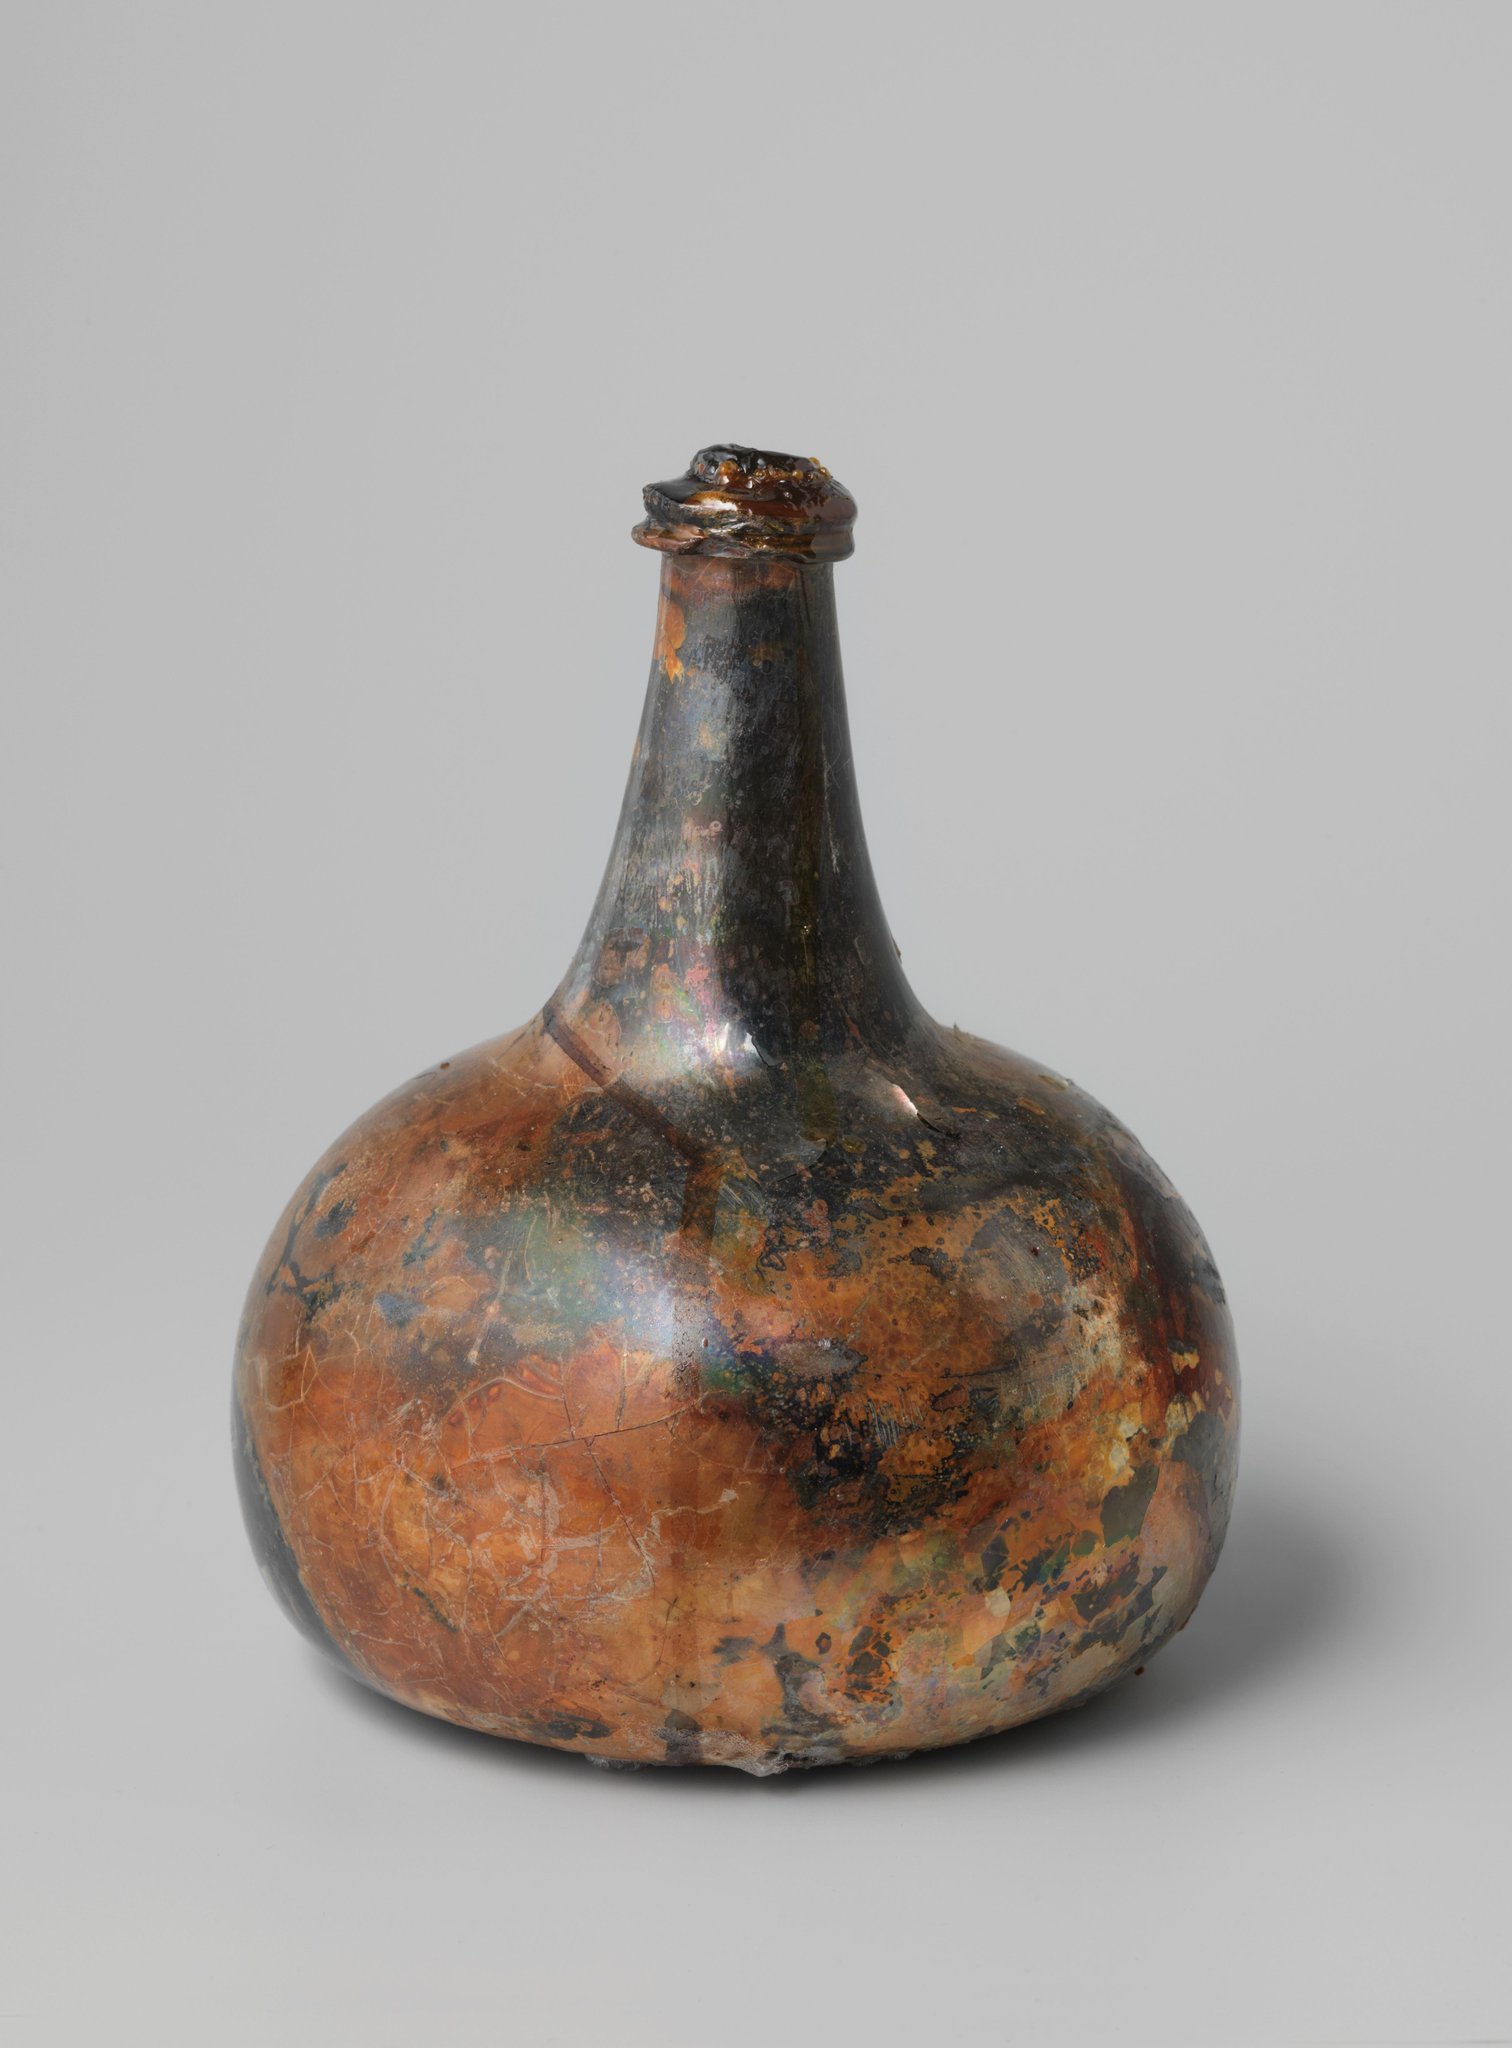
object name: wine bottle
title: Wijnfles met wijn uit het wrak van de Oost-Indiëvaarder 't Vliegend Hart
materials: glass, liquid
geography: netherlands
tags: 't vliegend hart (schip), verenigde oostindische compagnie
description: Uivormige wijnfles van groen glas gevuld met rode (port)wijn, afgesloten met een kurk. De draad die de kurk op de fles moest houden is verdwenen.